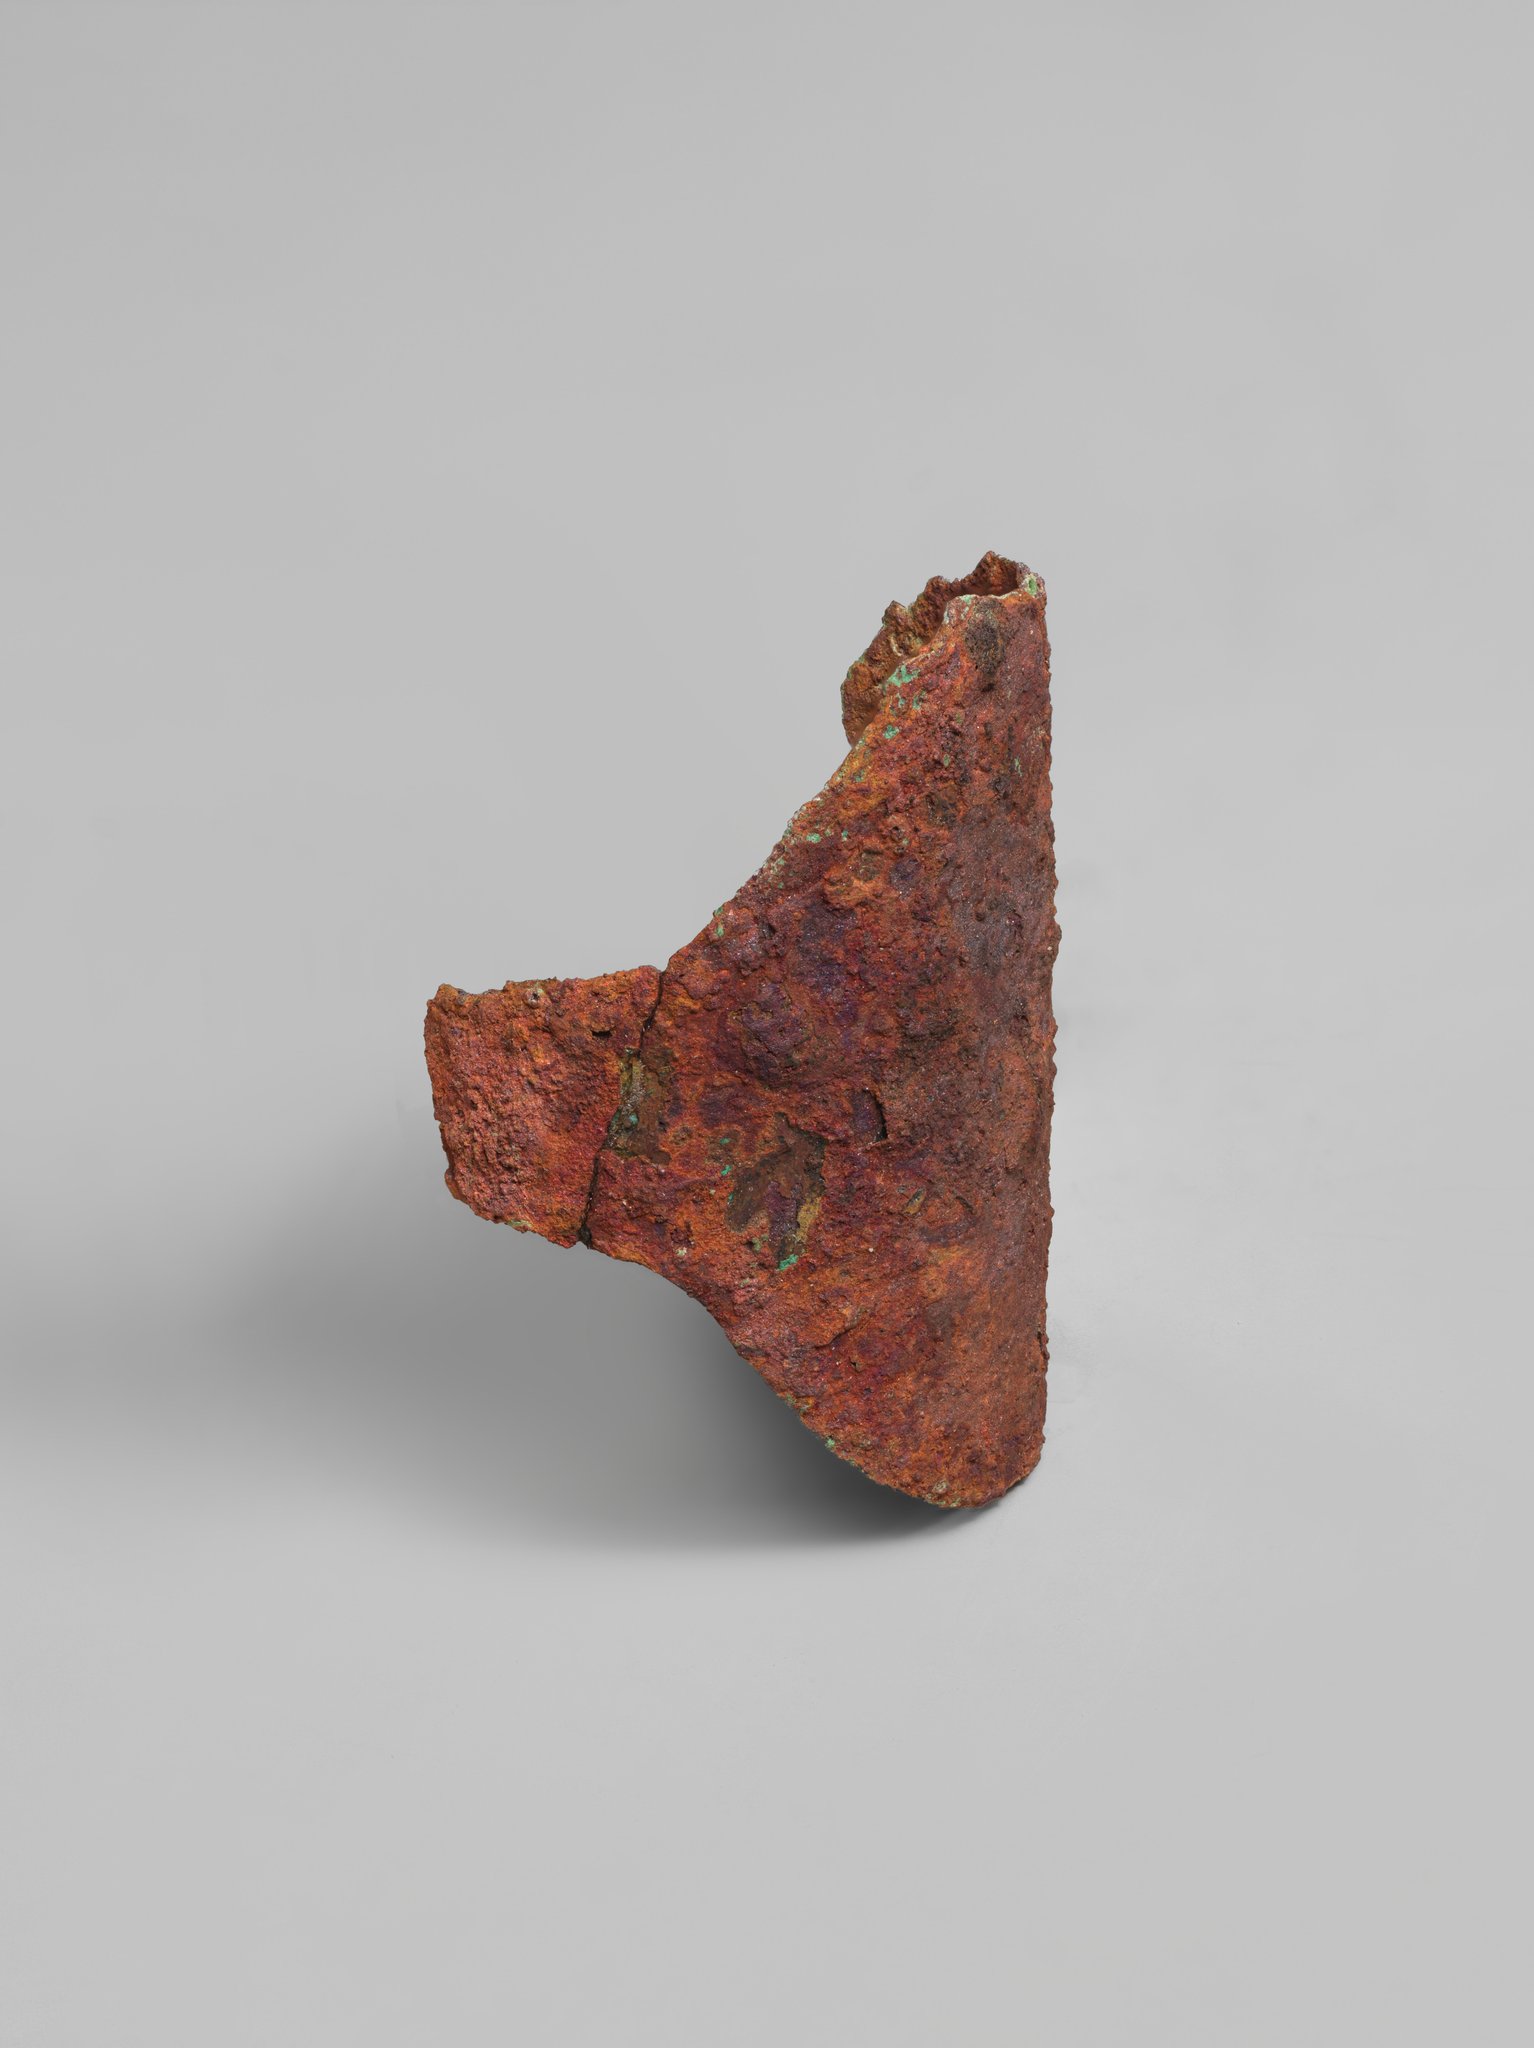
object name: ring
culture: iranian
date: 900-801 BCE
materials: bronze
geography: iran